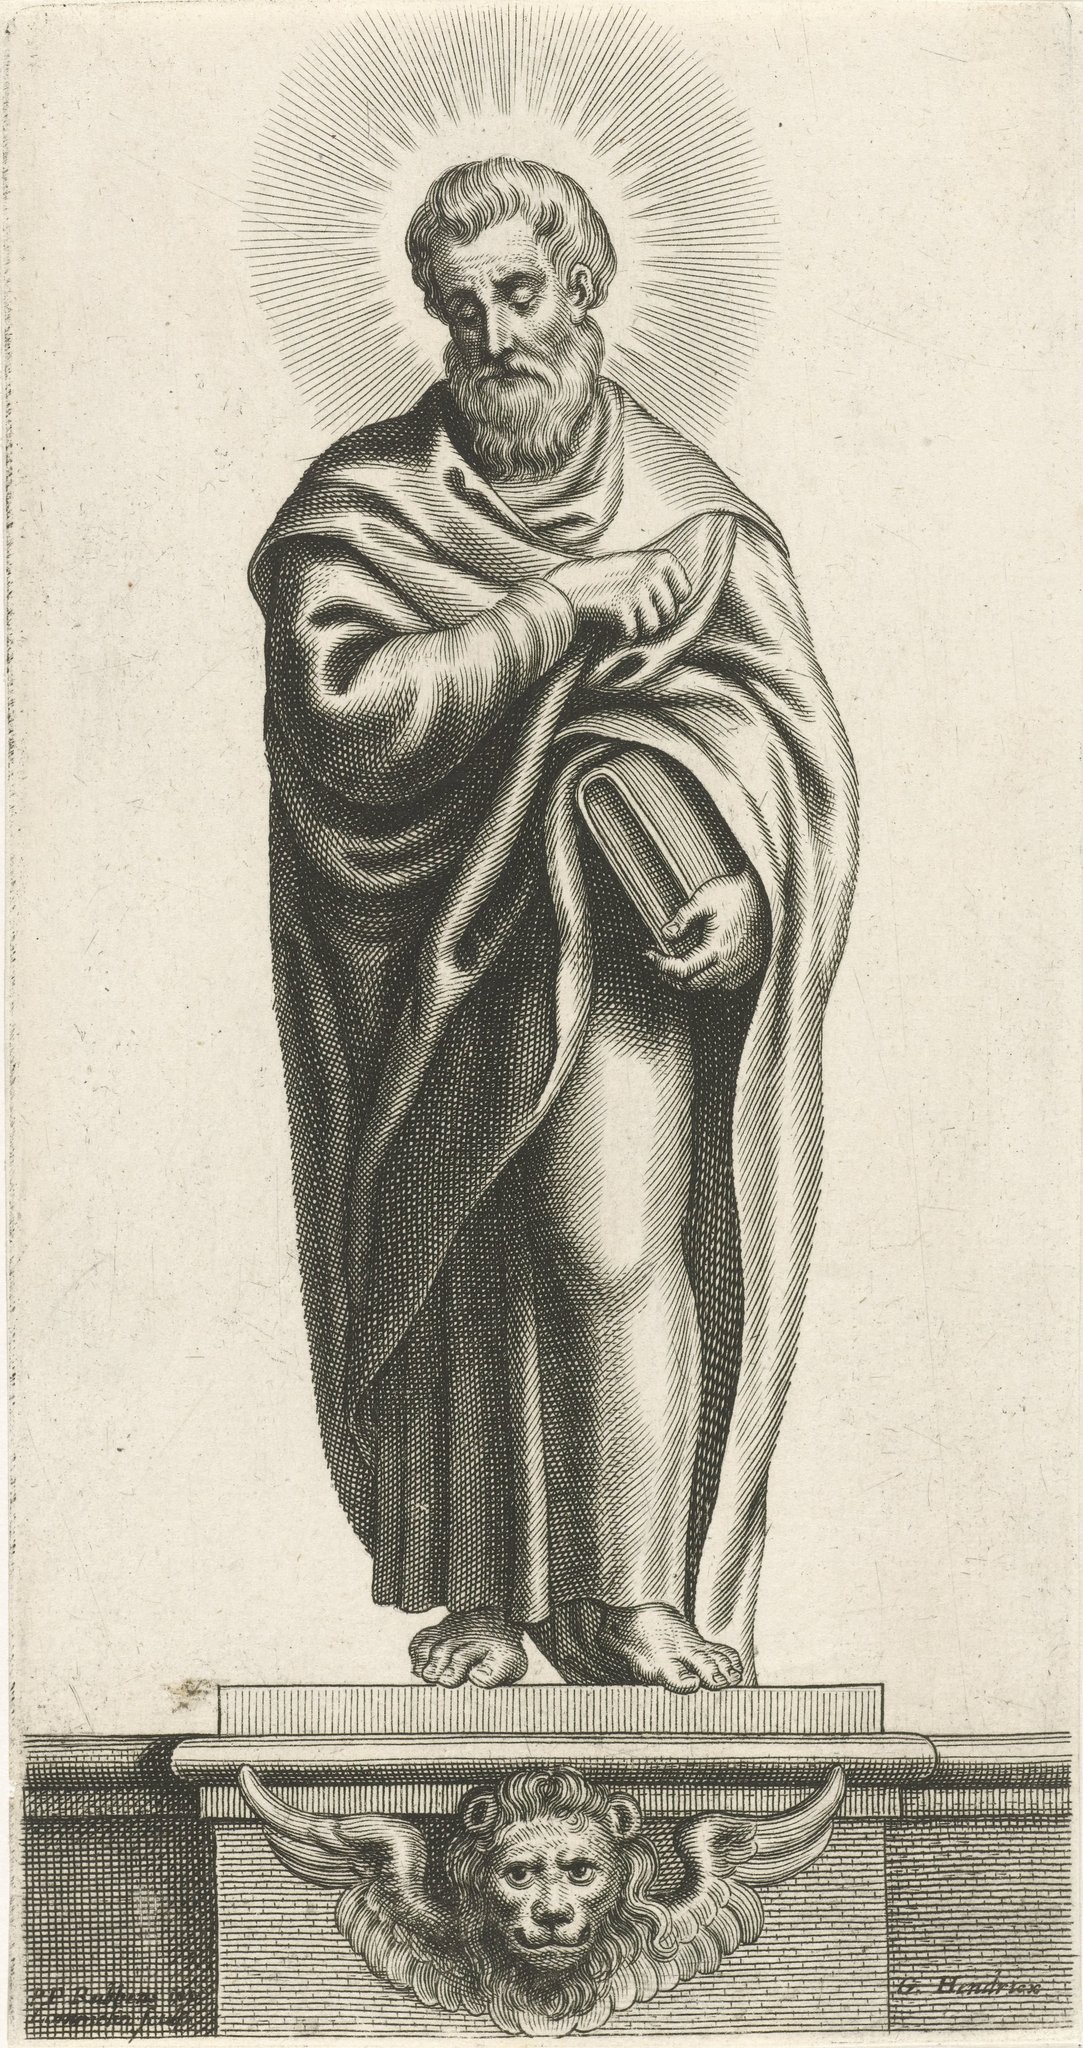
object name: print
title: Evangelist Marcus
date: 1630-1677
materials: paper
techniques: engraving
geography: antwerp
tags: mark (marcus) the evangelist, and bishop of alexandria; possible attributes: book, (winged) lion, pen and inkhorn, scroll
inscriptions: collector's mark: Lugt 240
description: Marcus de evangelist met een boek onder zijn arm. De sokkel waarop de evangelist staat, is versierd met een gevleugelde leeuw. De prent maakt deel uit van een vierdelige serie met voorstellingen van de vier evangelisten.